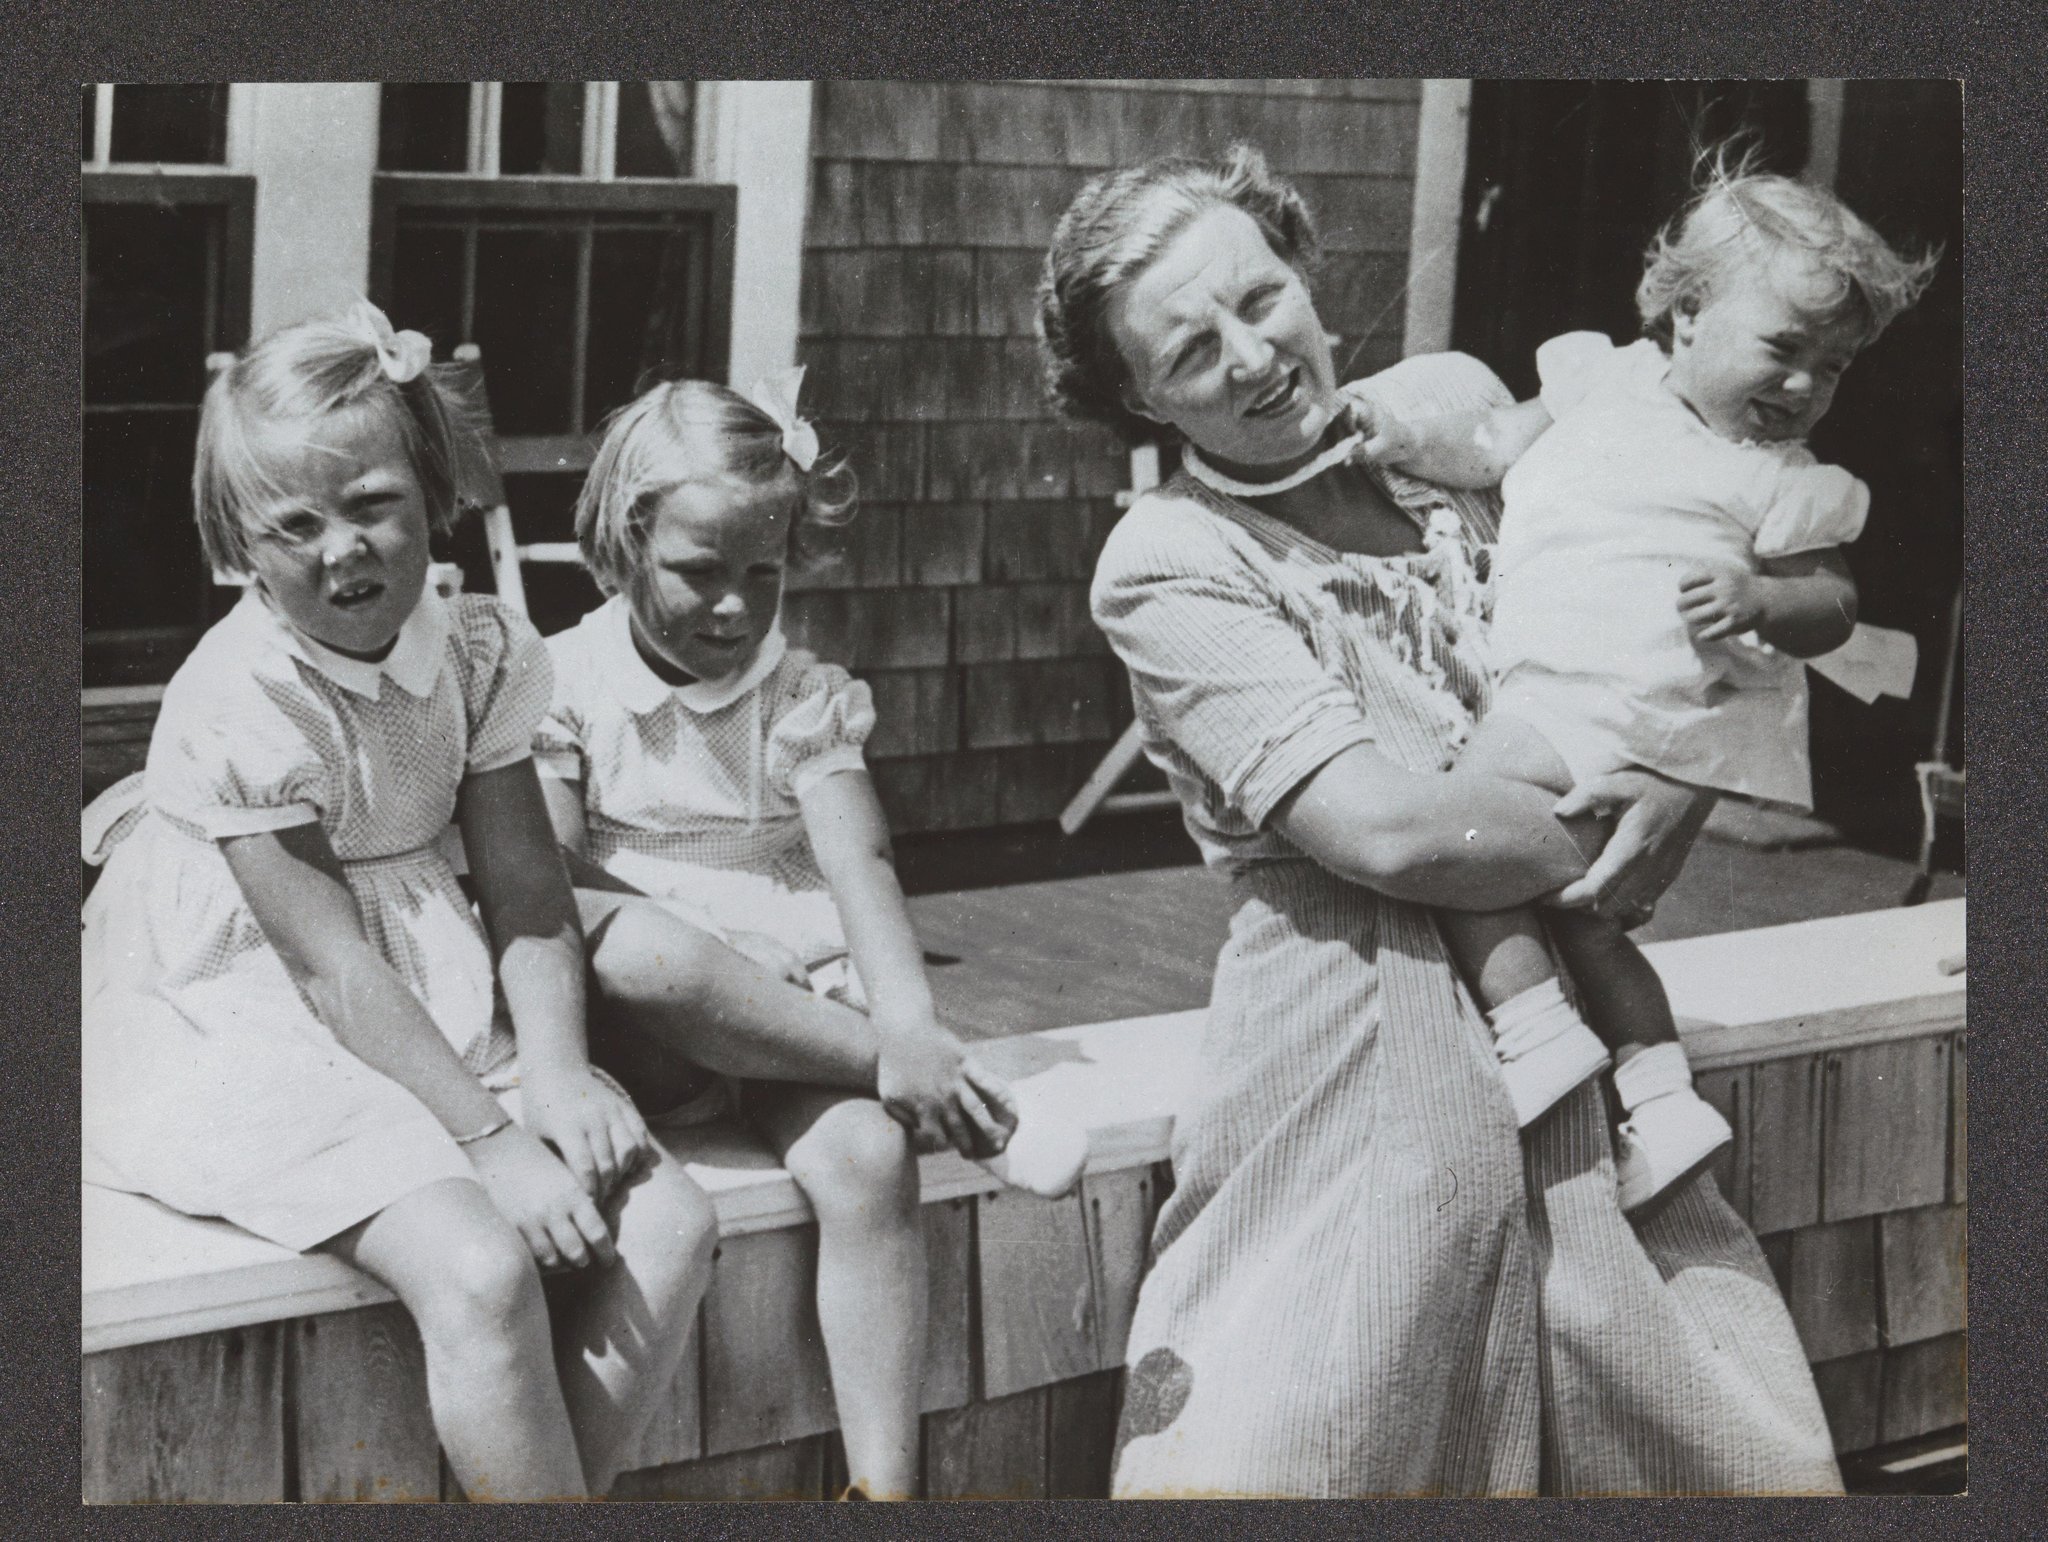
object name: photograph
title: Koningin Juliana met de prinsessen Beatrix, Irene en Margriet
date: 1945-1965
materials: paper, photographic support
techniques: gelatin silver print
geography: netherlands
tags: beatrix (koningin der nederlanden), the hague, juliana of the netherlands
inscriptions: annotation: ‘Copiright ANEFO Kerkstraat 310 Amsterdam-c’